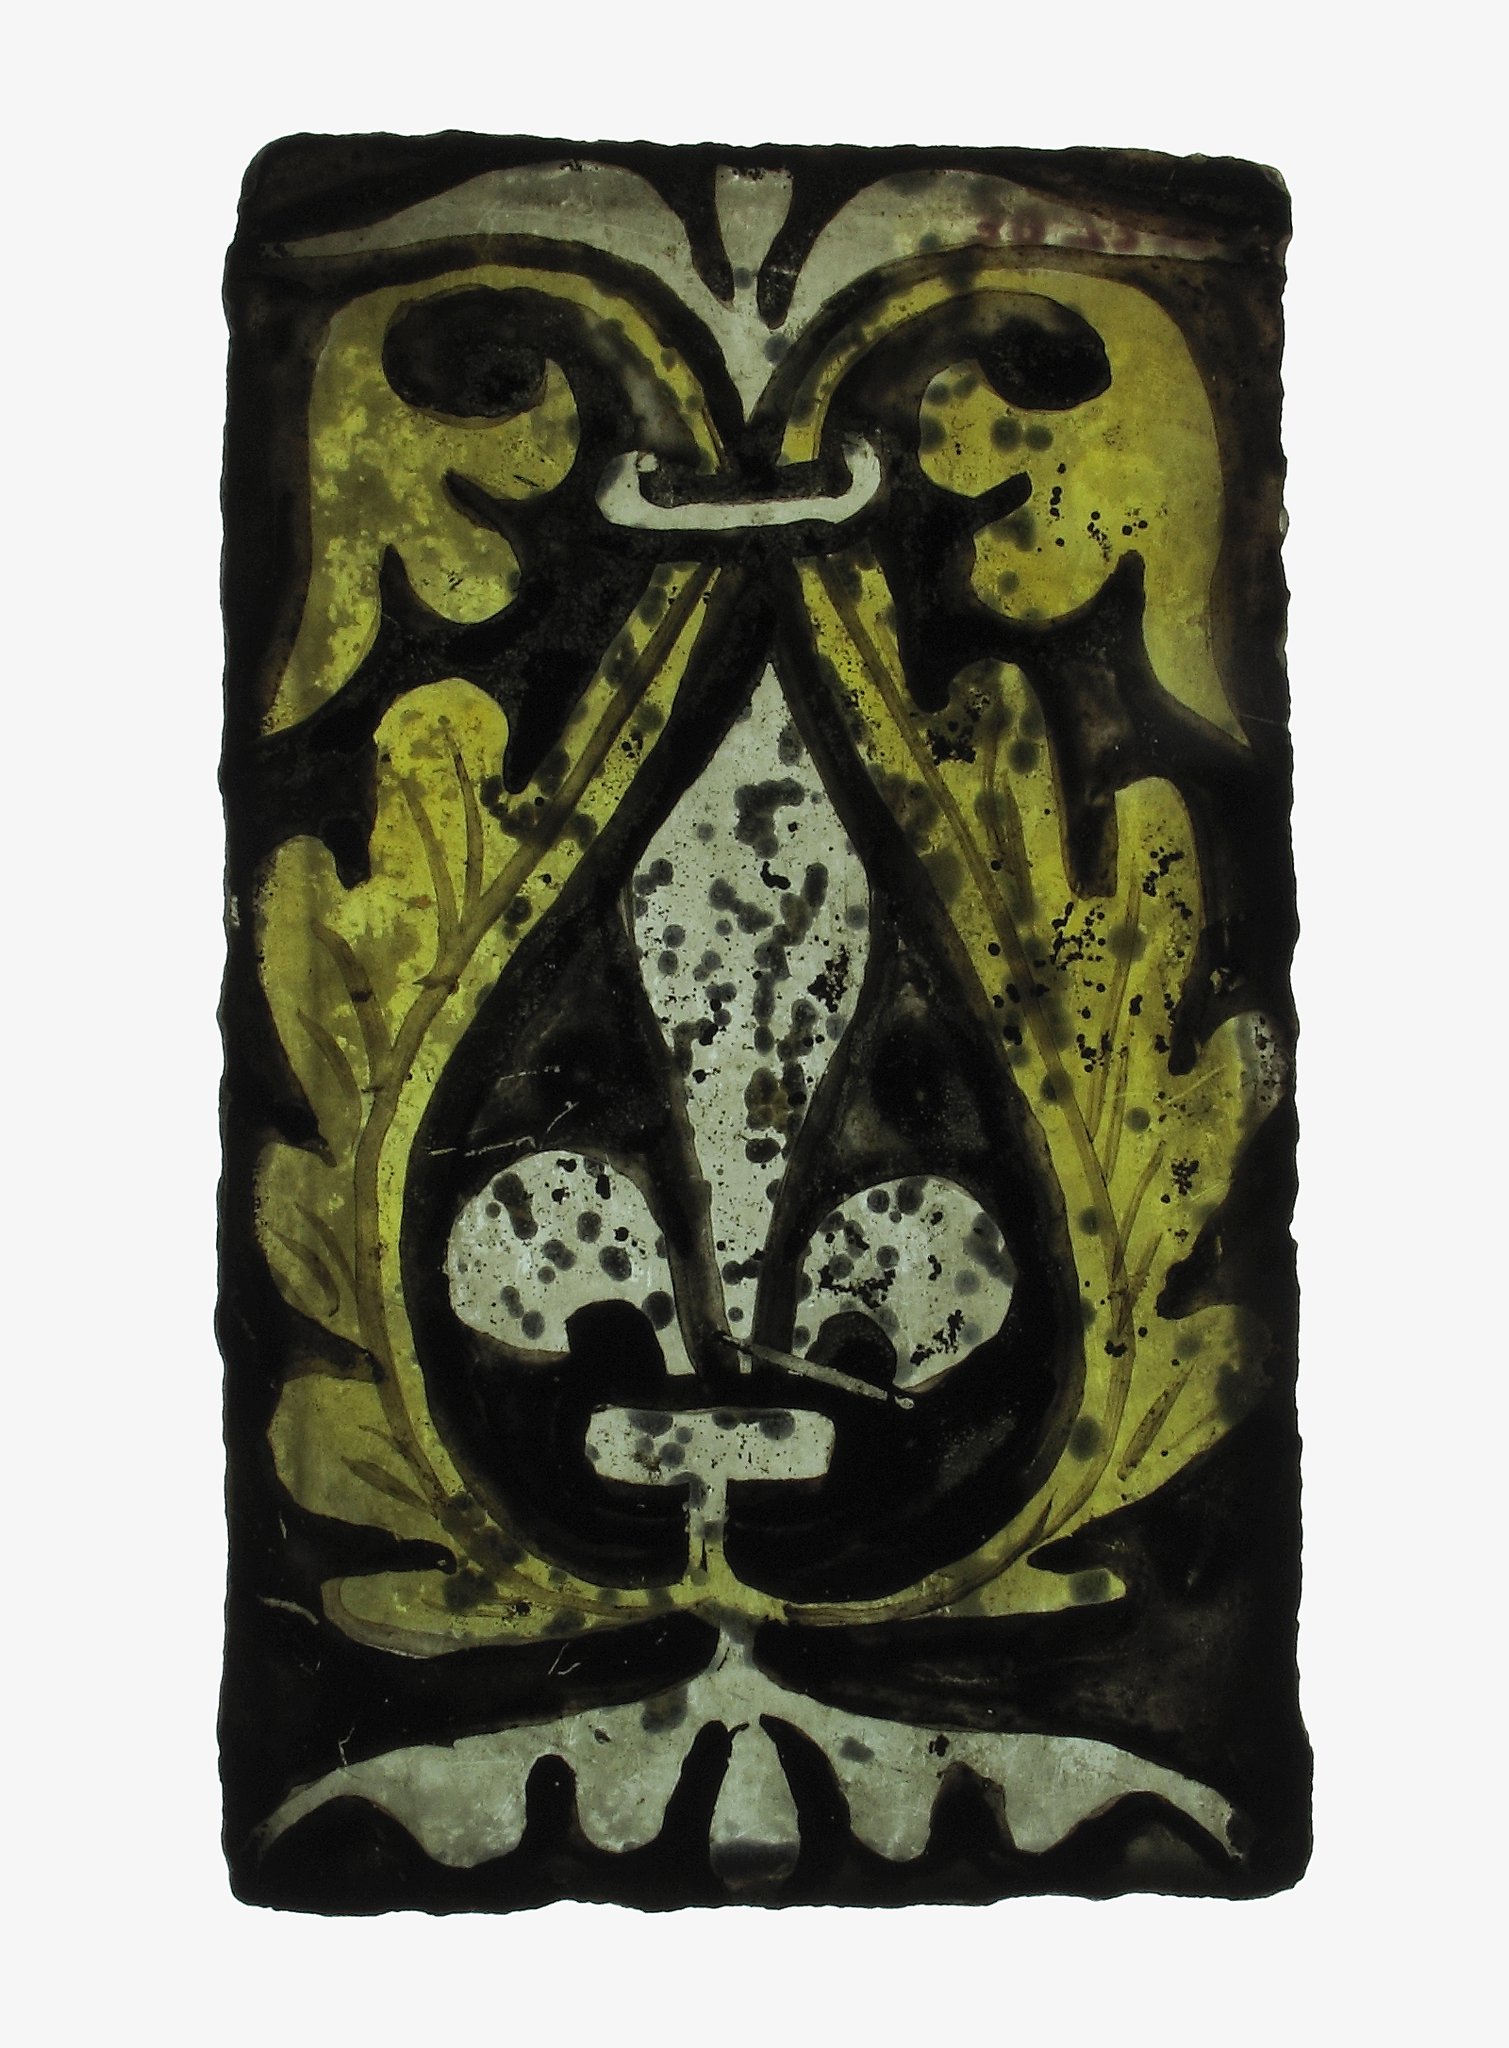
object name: fragment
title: Glass Fragment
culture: european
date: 1401-1500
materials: glass